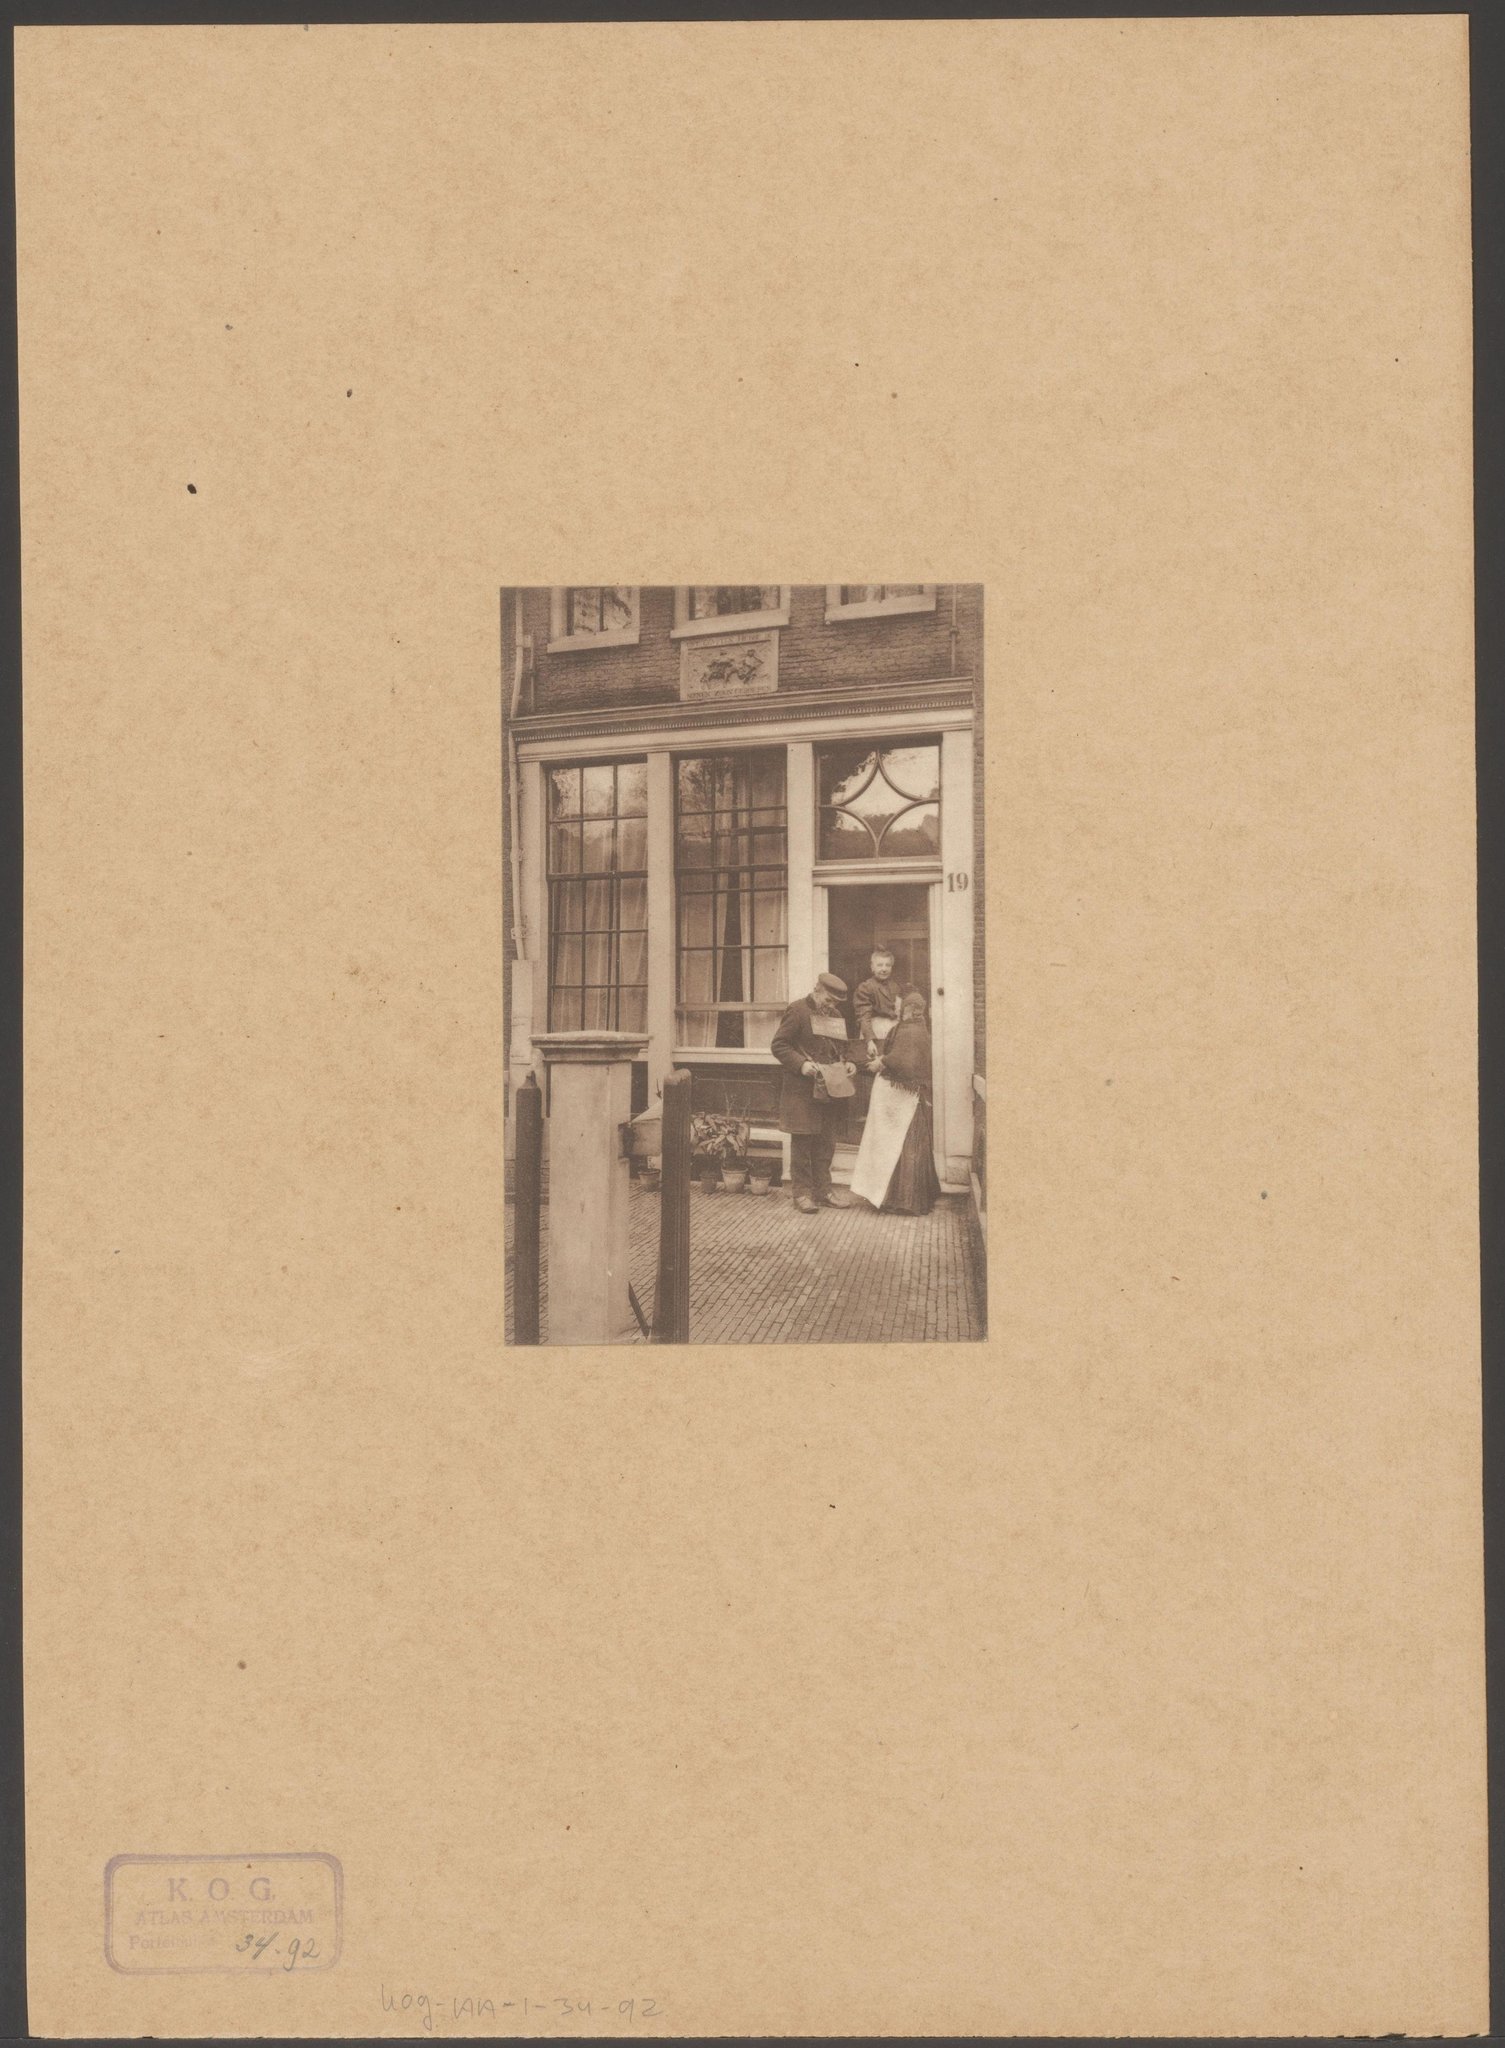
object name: photomechanical print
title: Drie personen voor de deur van Begijnhof 19 te Amsterdam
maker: Anonymous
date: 1905-1930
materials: paper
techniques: photograph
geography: netherlands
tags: urban housing, stone tablet in façade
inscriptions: collector's mark: Lugt 1641b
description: Onderwerpsrubriek binnen de Atlas Amsterdam: Kerkwezen: R.K. Gemeenten: Begijnhof t/m Petrus en Paulus.